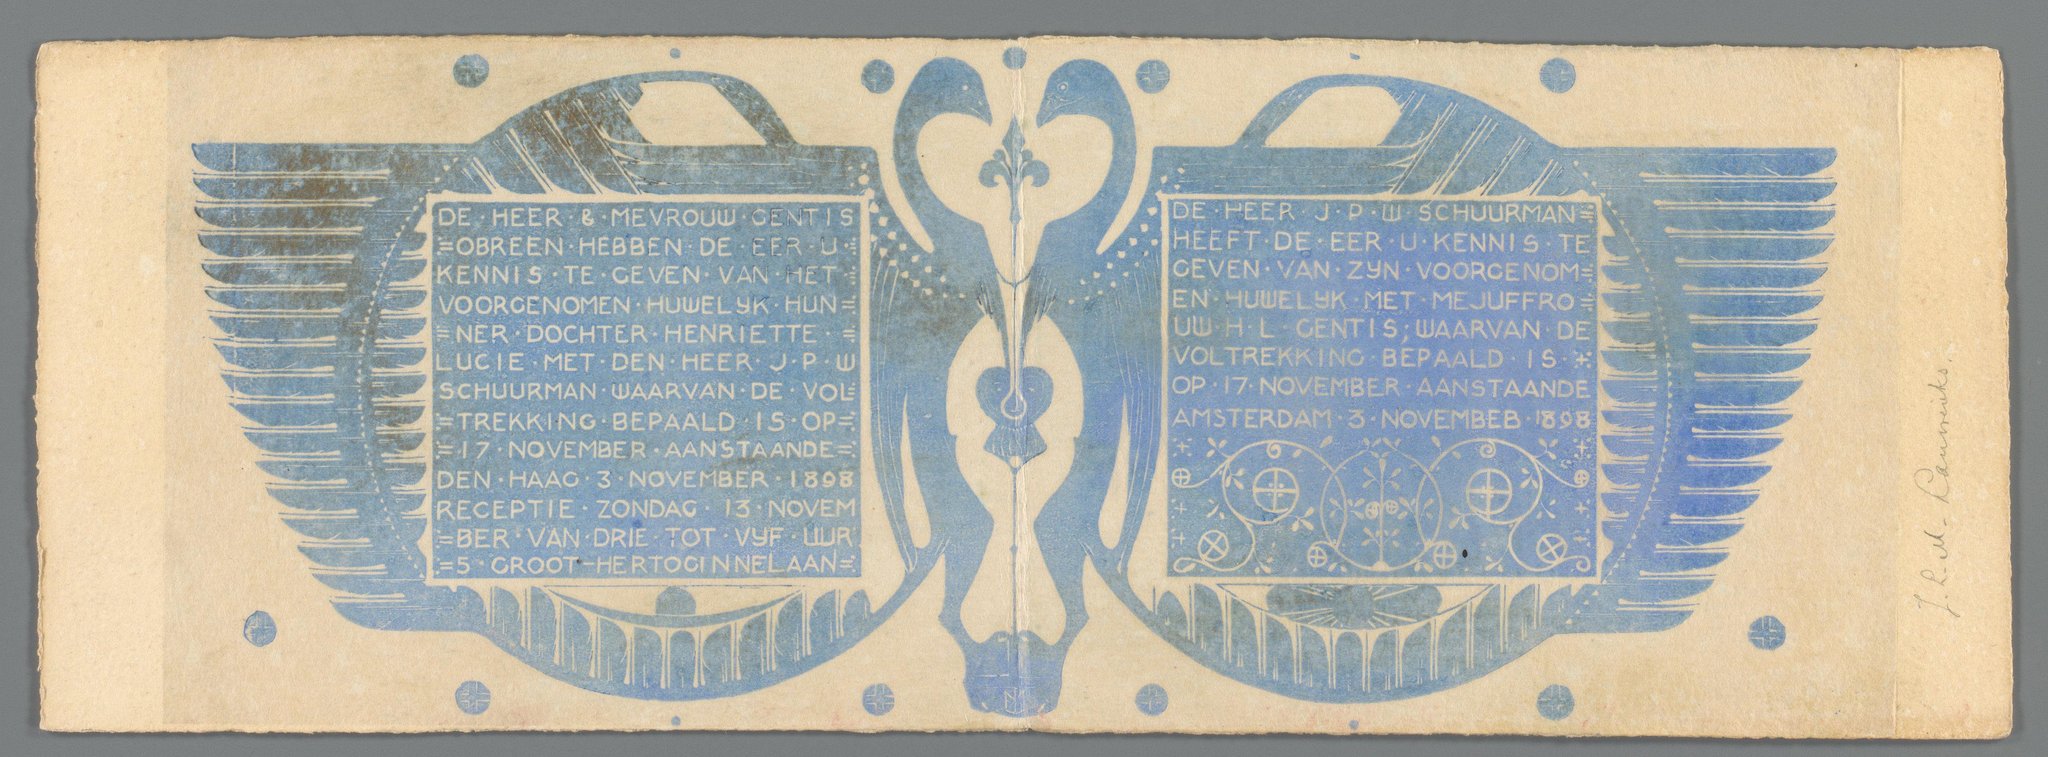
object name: print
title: Verlovingsaankondiging van Henriette Lucie Gentis en J.P.W. Schuurman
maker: mathieu lauweriks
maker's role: designer, draughtsman, print maker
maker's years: 1864-1932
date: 1898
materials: paper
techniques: woodcut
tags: birds, betrothal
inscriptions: date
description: Op de voorzijde een verweven letter G en een letter S. Binnenin een kader in de vorm van een gespiegelde vogel met links en rechts tekstblokken. Links de aankondiging van het huwelijk vanuit de ouders van Henriette Lucie Gentis; rechts de aankondiging van J.P.W. Schuurman. Het huwelijk zou voltrokken worden op 17 november 1898 in Amsterdam.